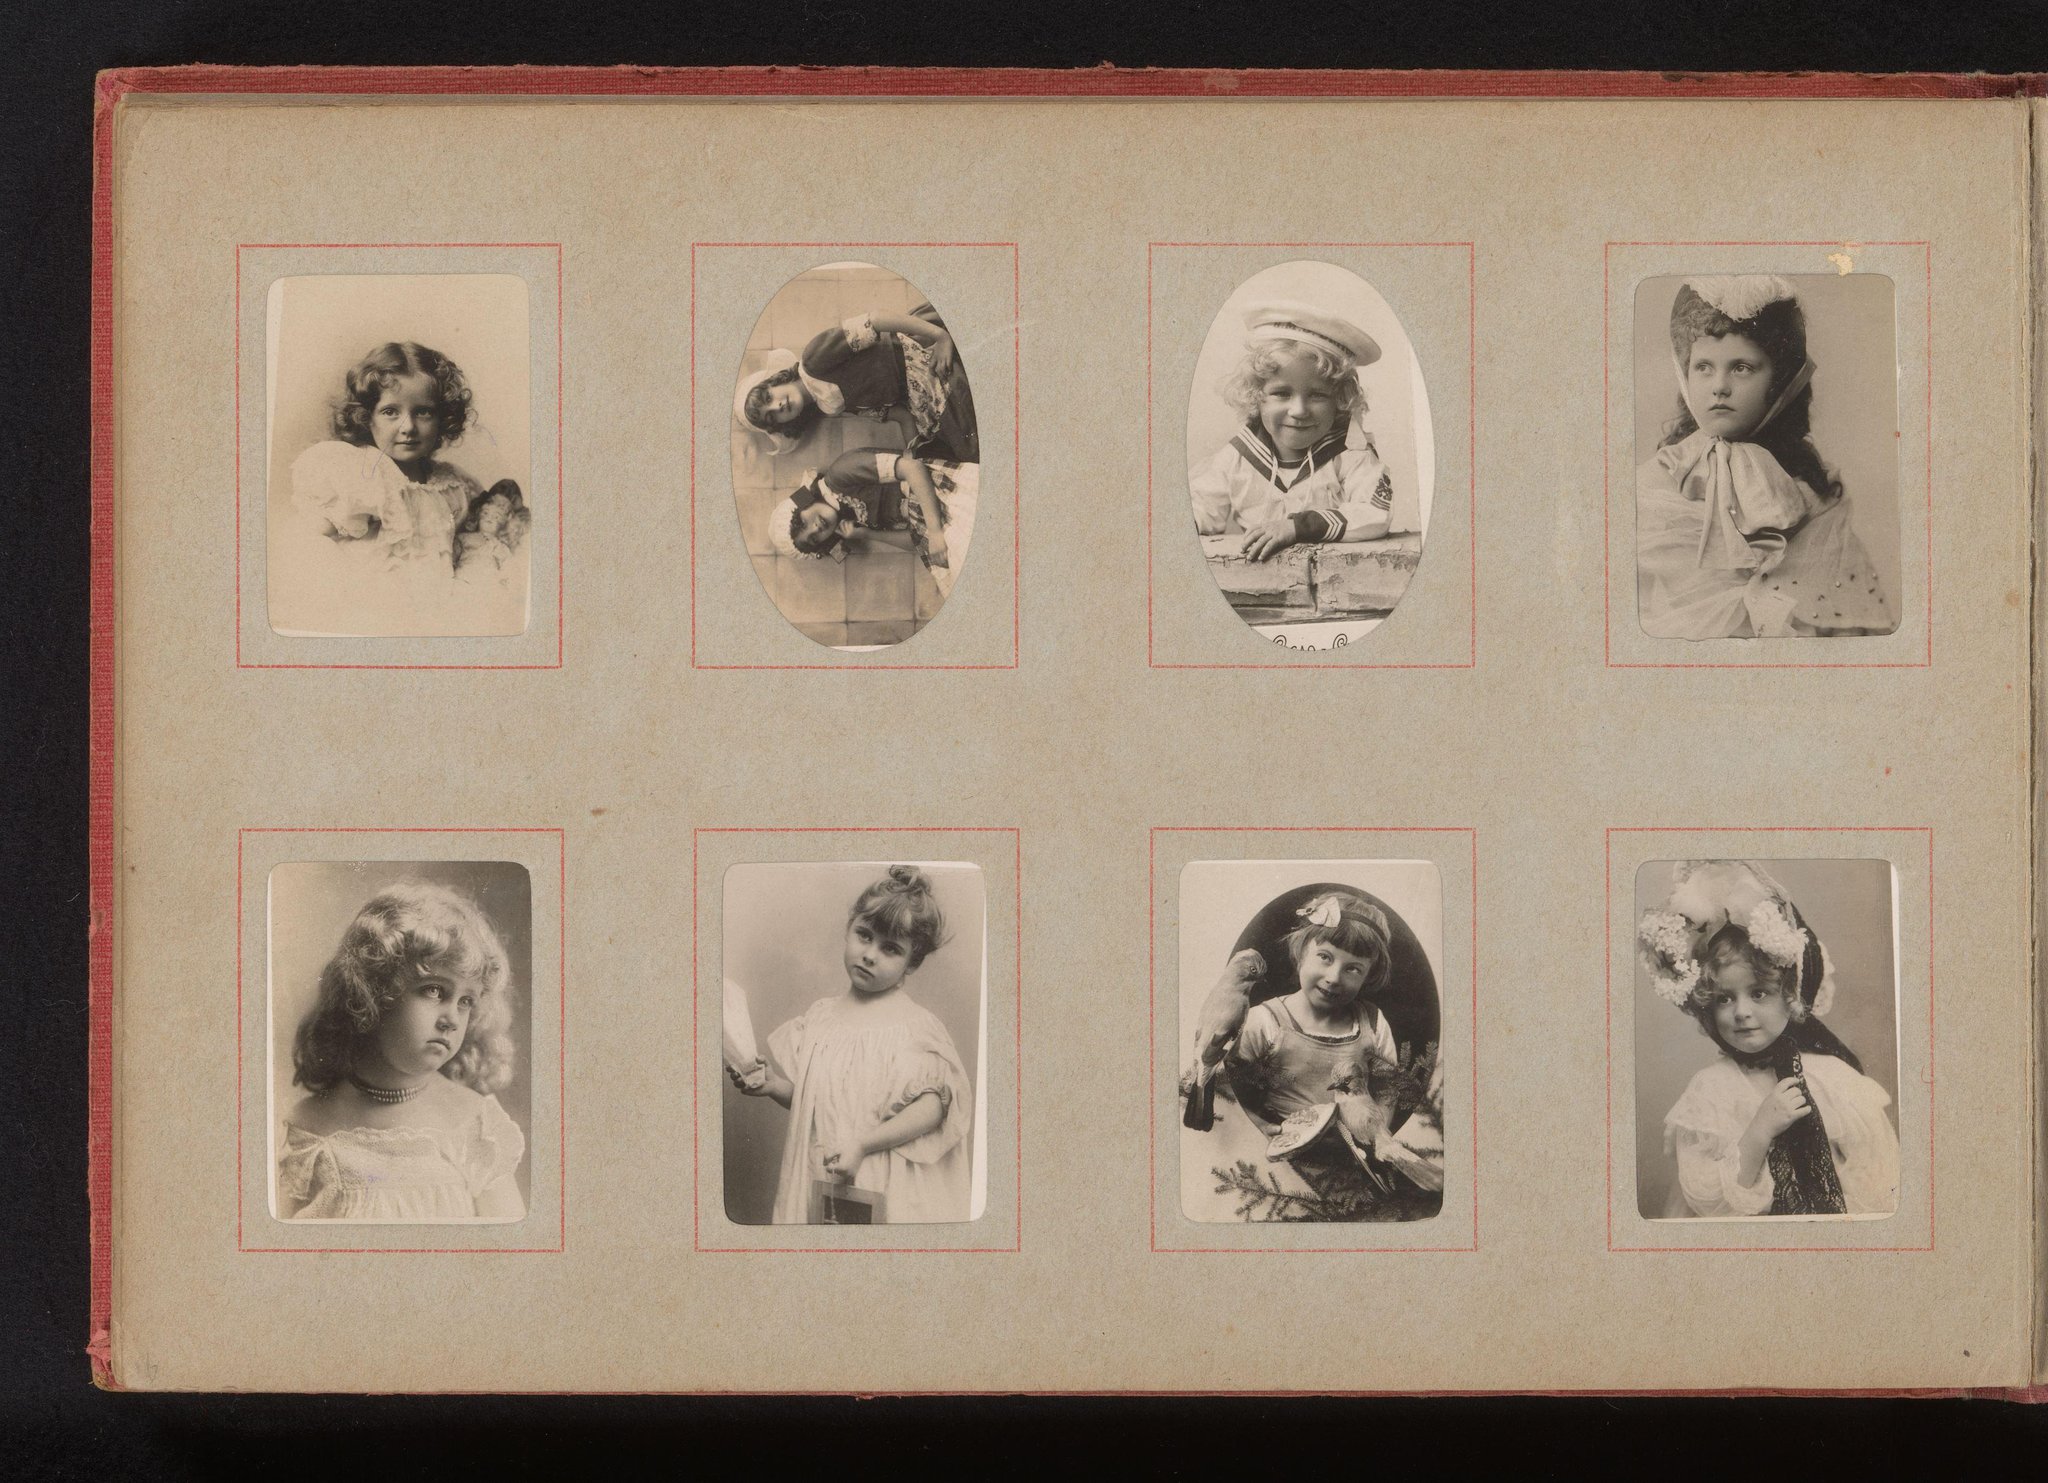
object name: photograph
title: Kinderportretten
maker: Anonymous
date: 1890-1900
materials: cardboard, photographic support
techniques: gelatin silver print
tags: birds, folk costume, regional costume, child (at home)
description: Acht portretten van kinderen, waaronder een portret van een meisje met vogels en twee meisjes in klederdracht. Deze pagina maakt deel uit van een album.